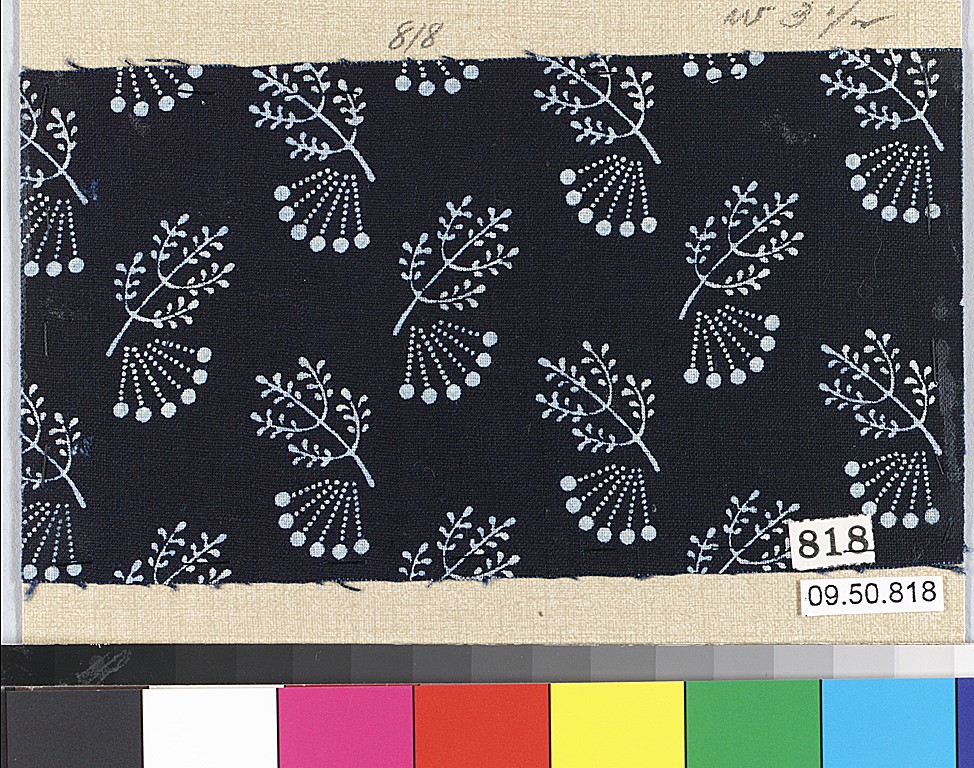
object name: piece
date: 1801-1900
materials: cotton